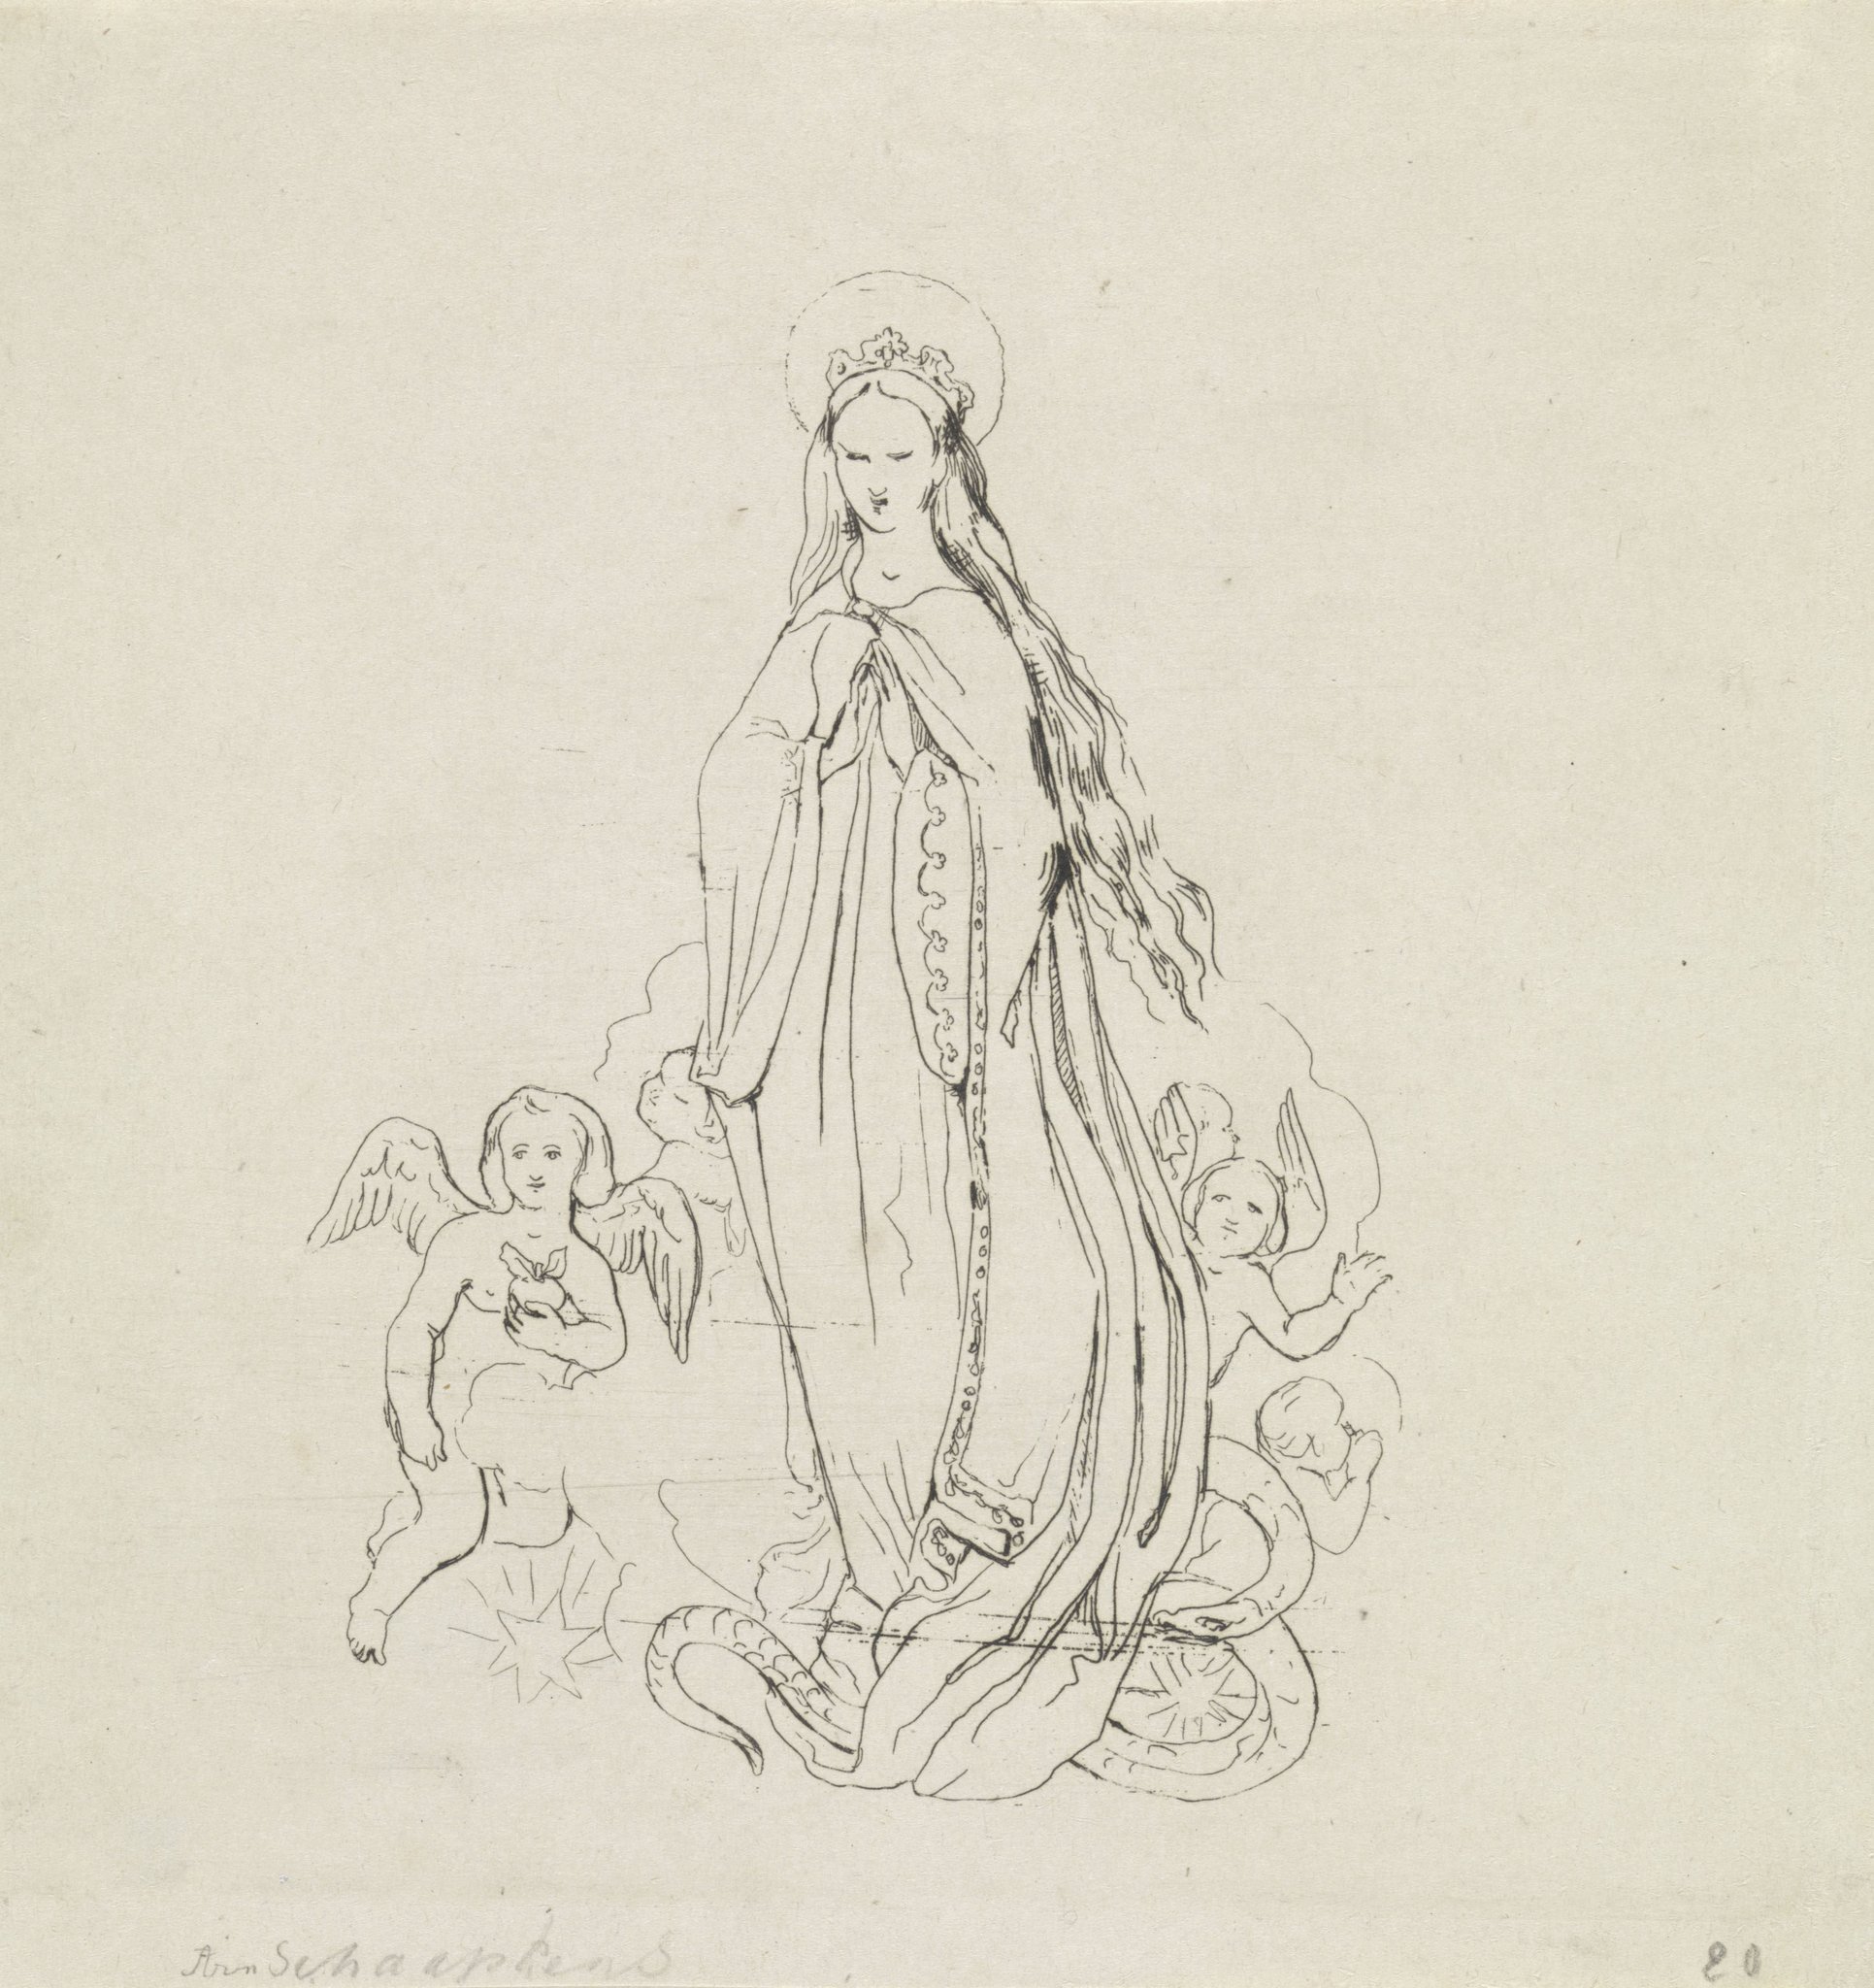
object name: print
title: H. Maagd met engelen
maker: arnoud schaepkens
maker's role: print maker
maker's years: 1816-1904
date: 1831-1904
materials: paper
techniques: etching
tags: the virgin mary, angels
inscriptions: collector's mark: Lugt 2228, collector's mark: Lugt 1485